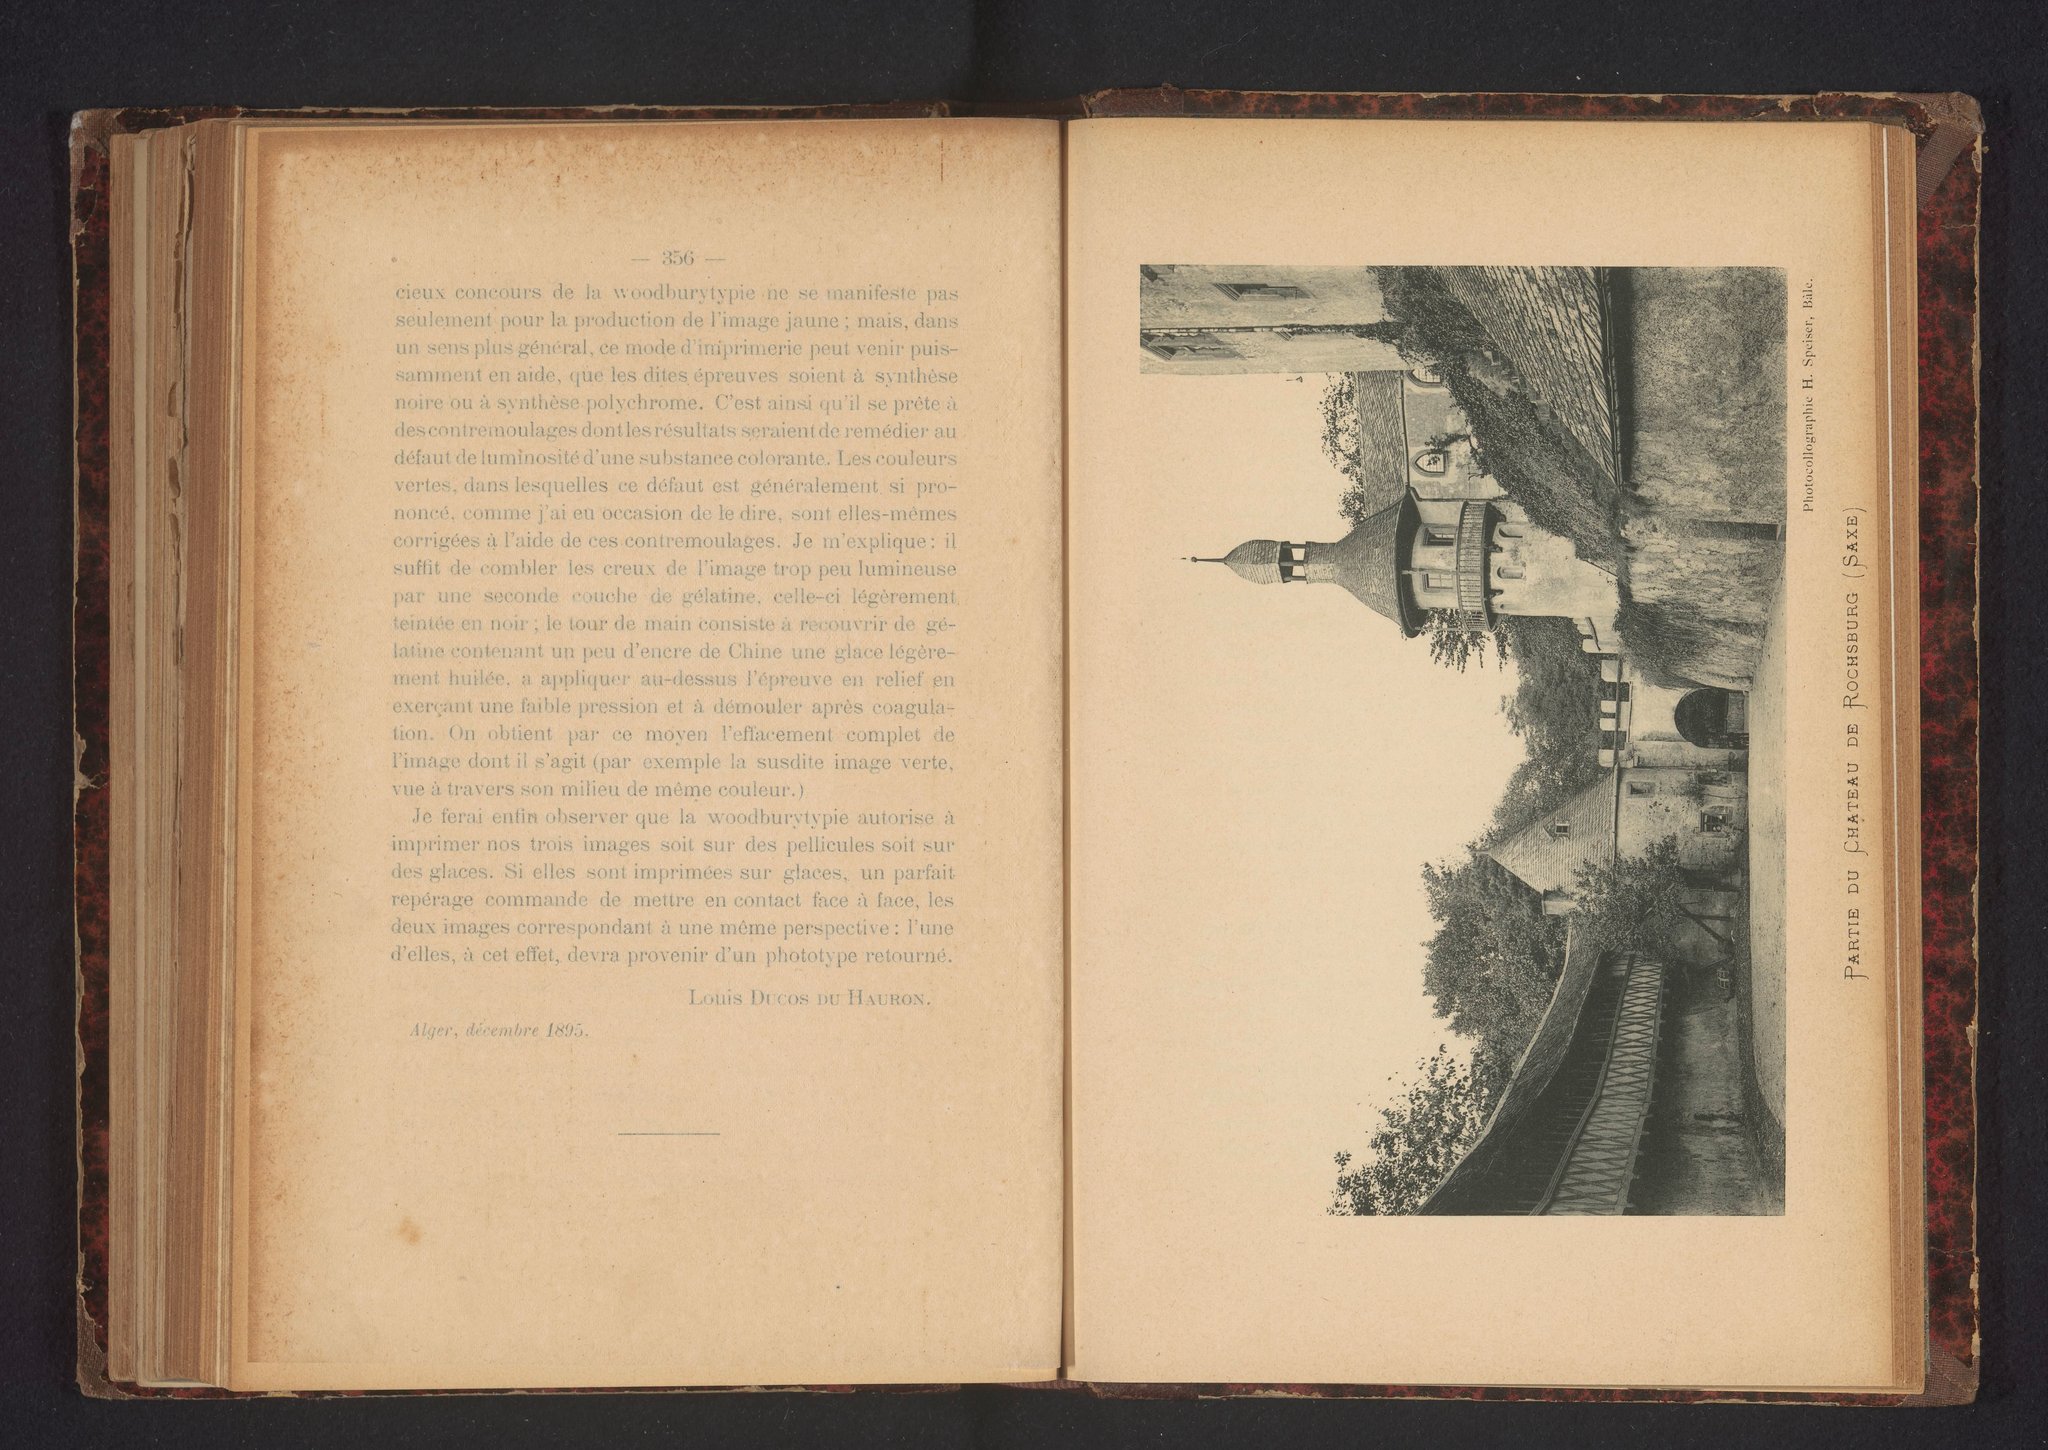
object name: photomechanical print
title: Partie du château de Rochsburg (Saxe)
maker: hans speiser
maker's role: fotograaf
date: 1890-1895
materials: paper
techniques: photograph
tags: castle, gate, entrance